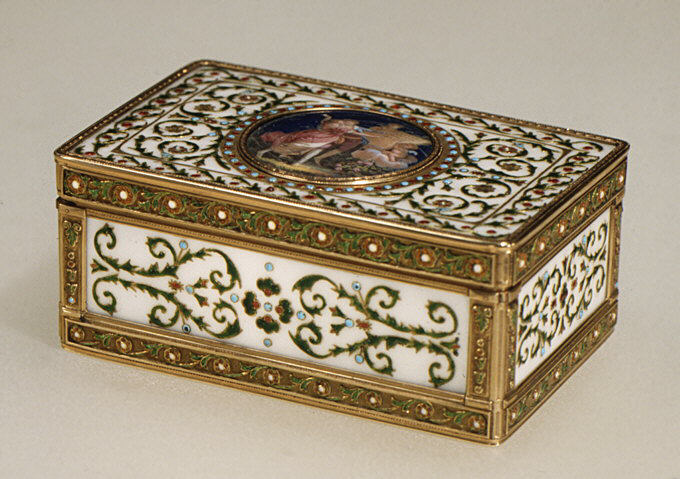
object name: snuffbox, painting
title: Snuffbox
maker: adrien jean maximilien vachette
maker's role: maker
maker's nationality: french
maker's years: 1753-1839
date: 1789-1790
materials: enamel, gold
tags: children,men,women,dogs